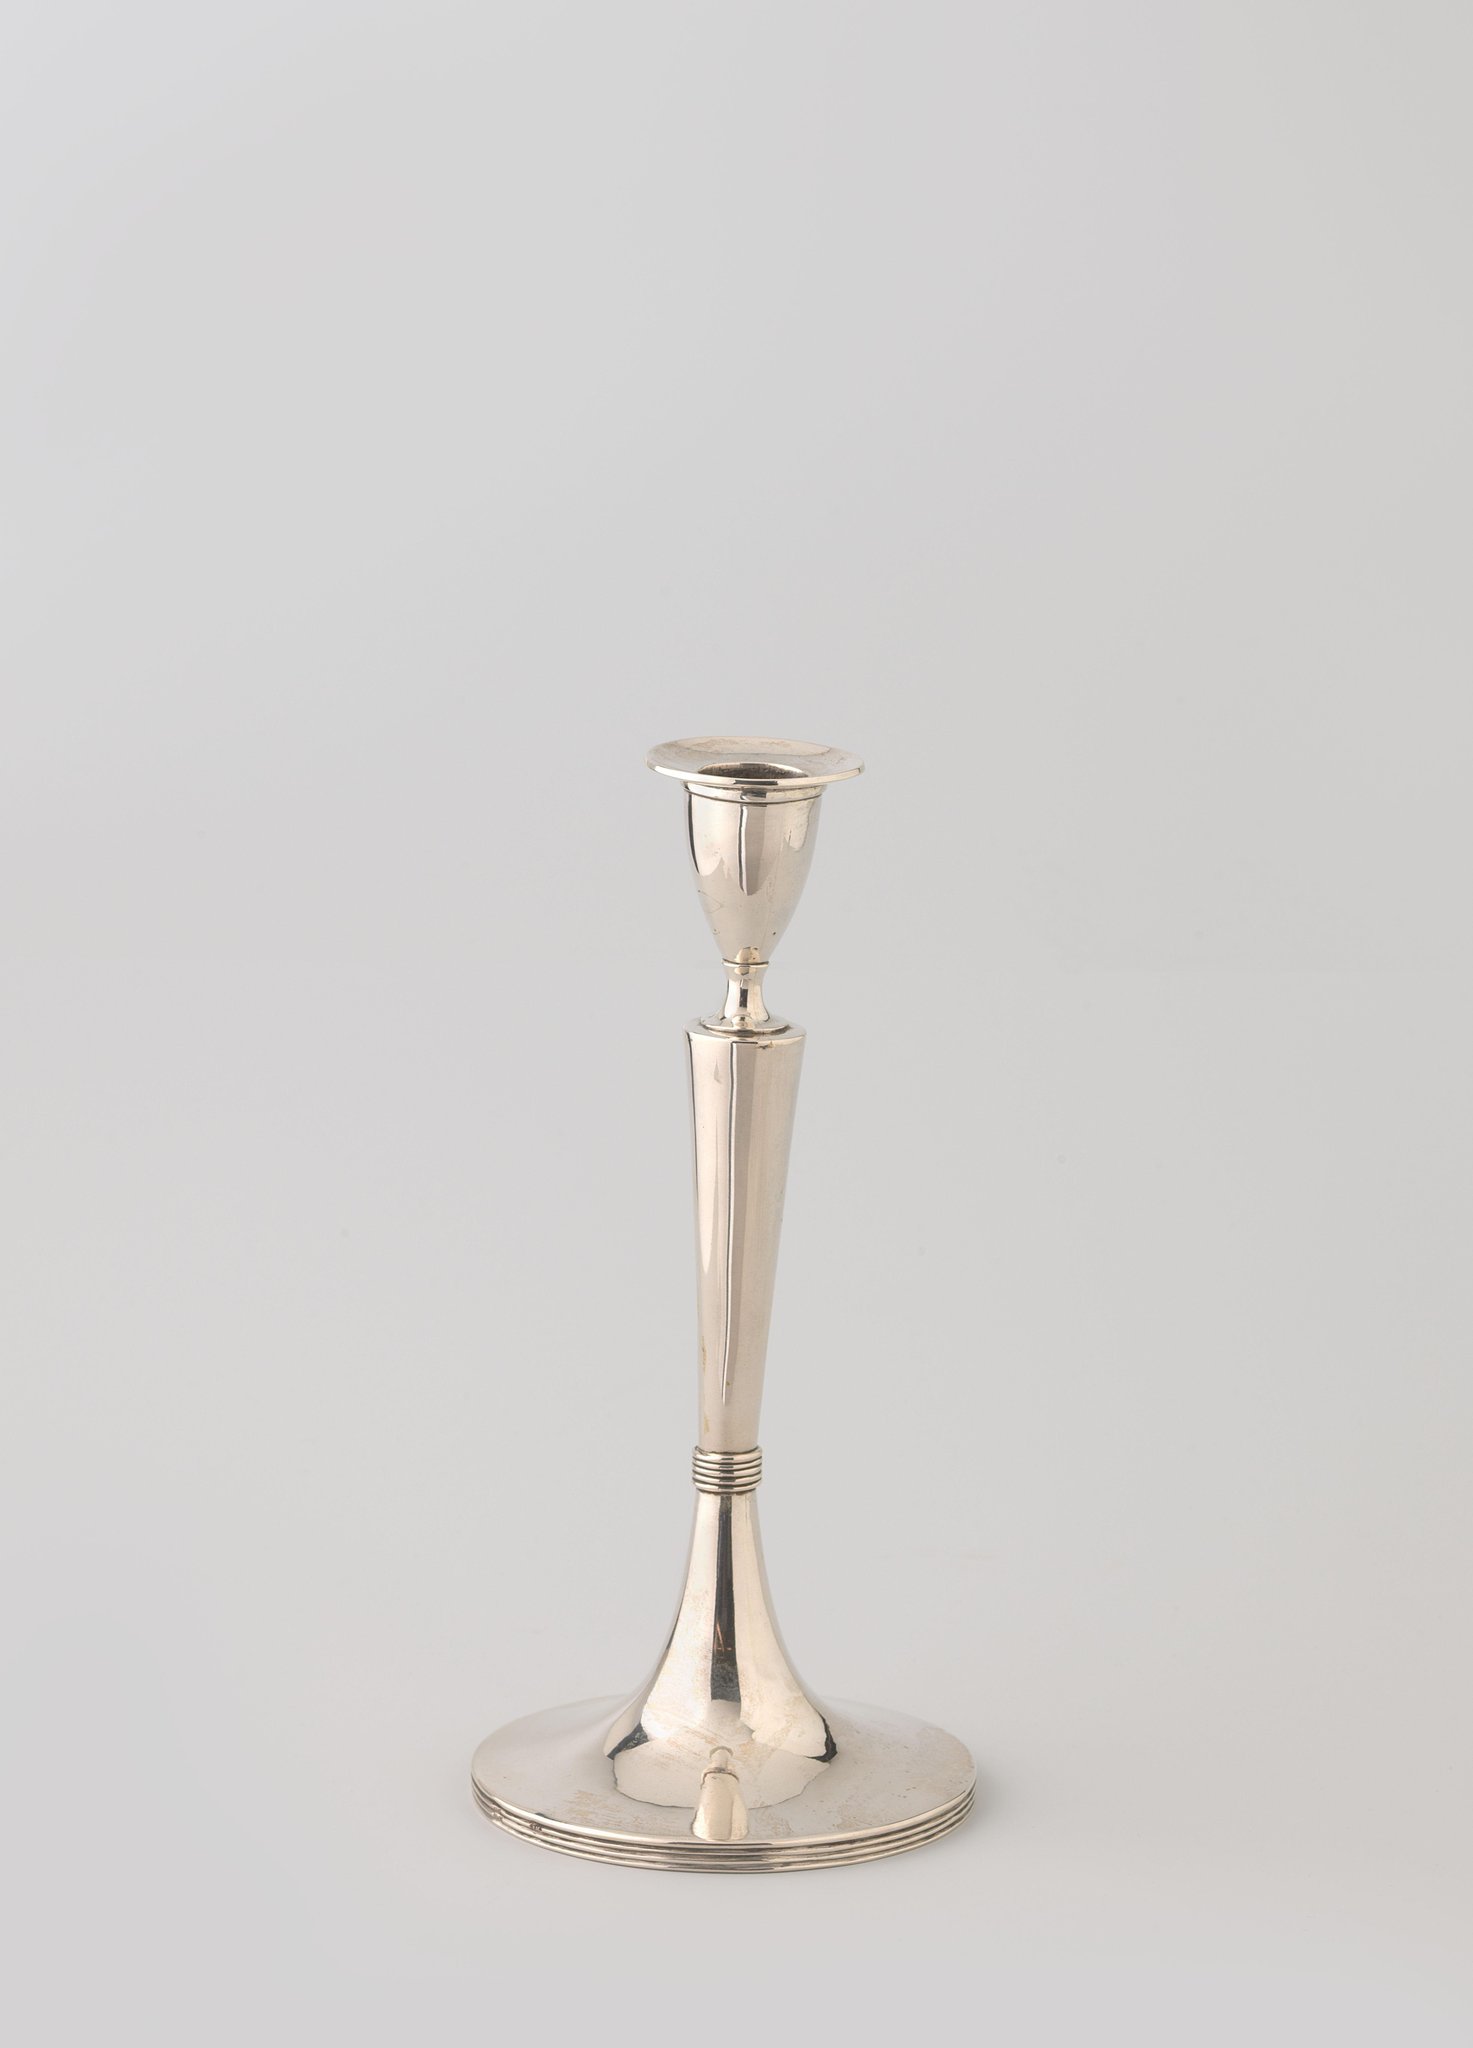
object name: candlestick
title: Kandelaar van zilver op trompetvormige voet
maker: Anonymous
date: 1813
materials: silver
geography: austria-hungary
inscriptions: mark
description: Four candlesticks. Silver. Vienna, 1815. Mrs J.E.F.E. de Kleyn-von Artner bequest, 1965.